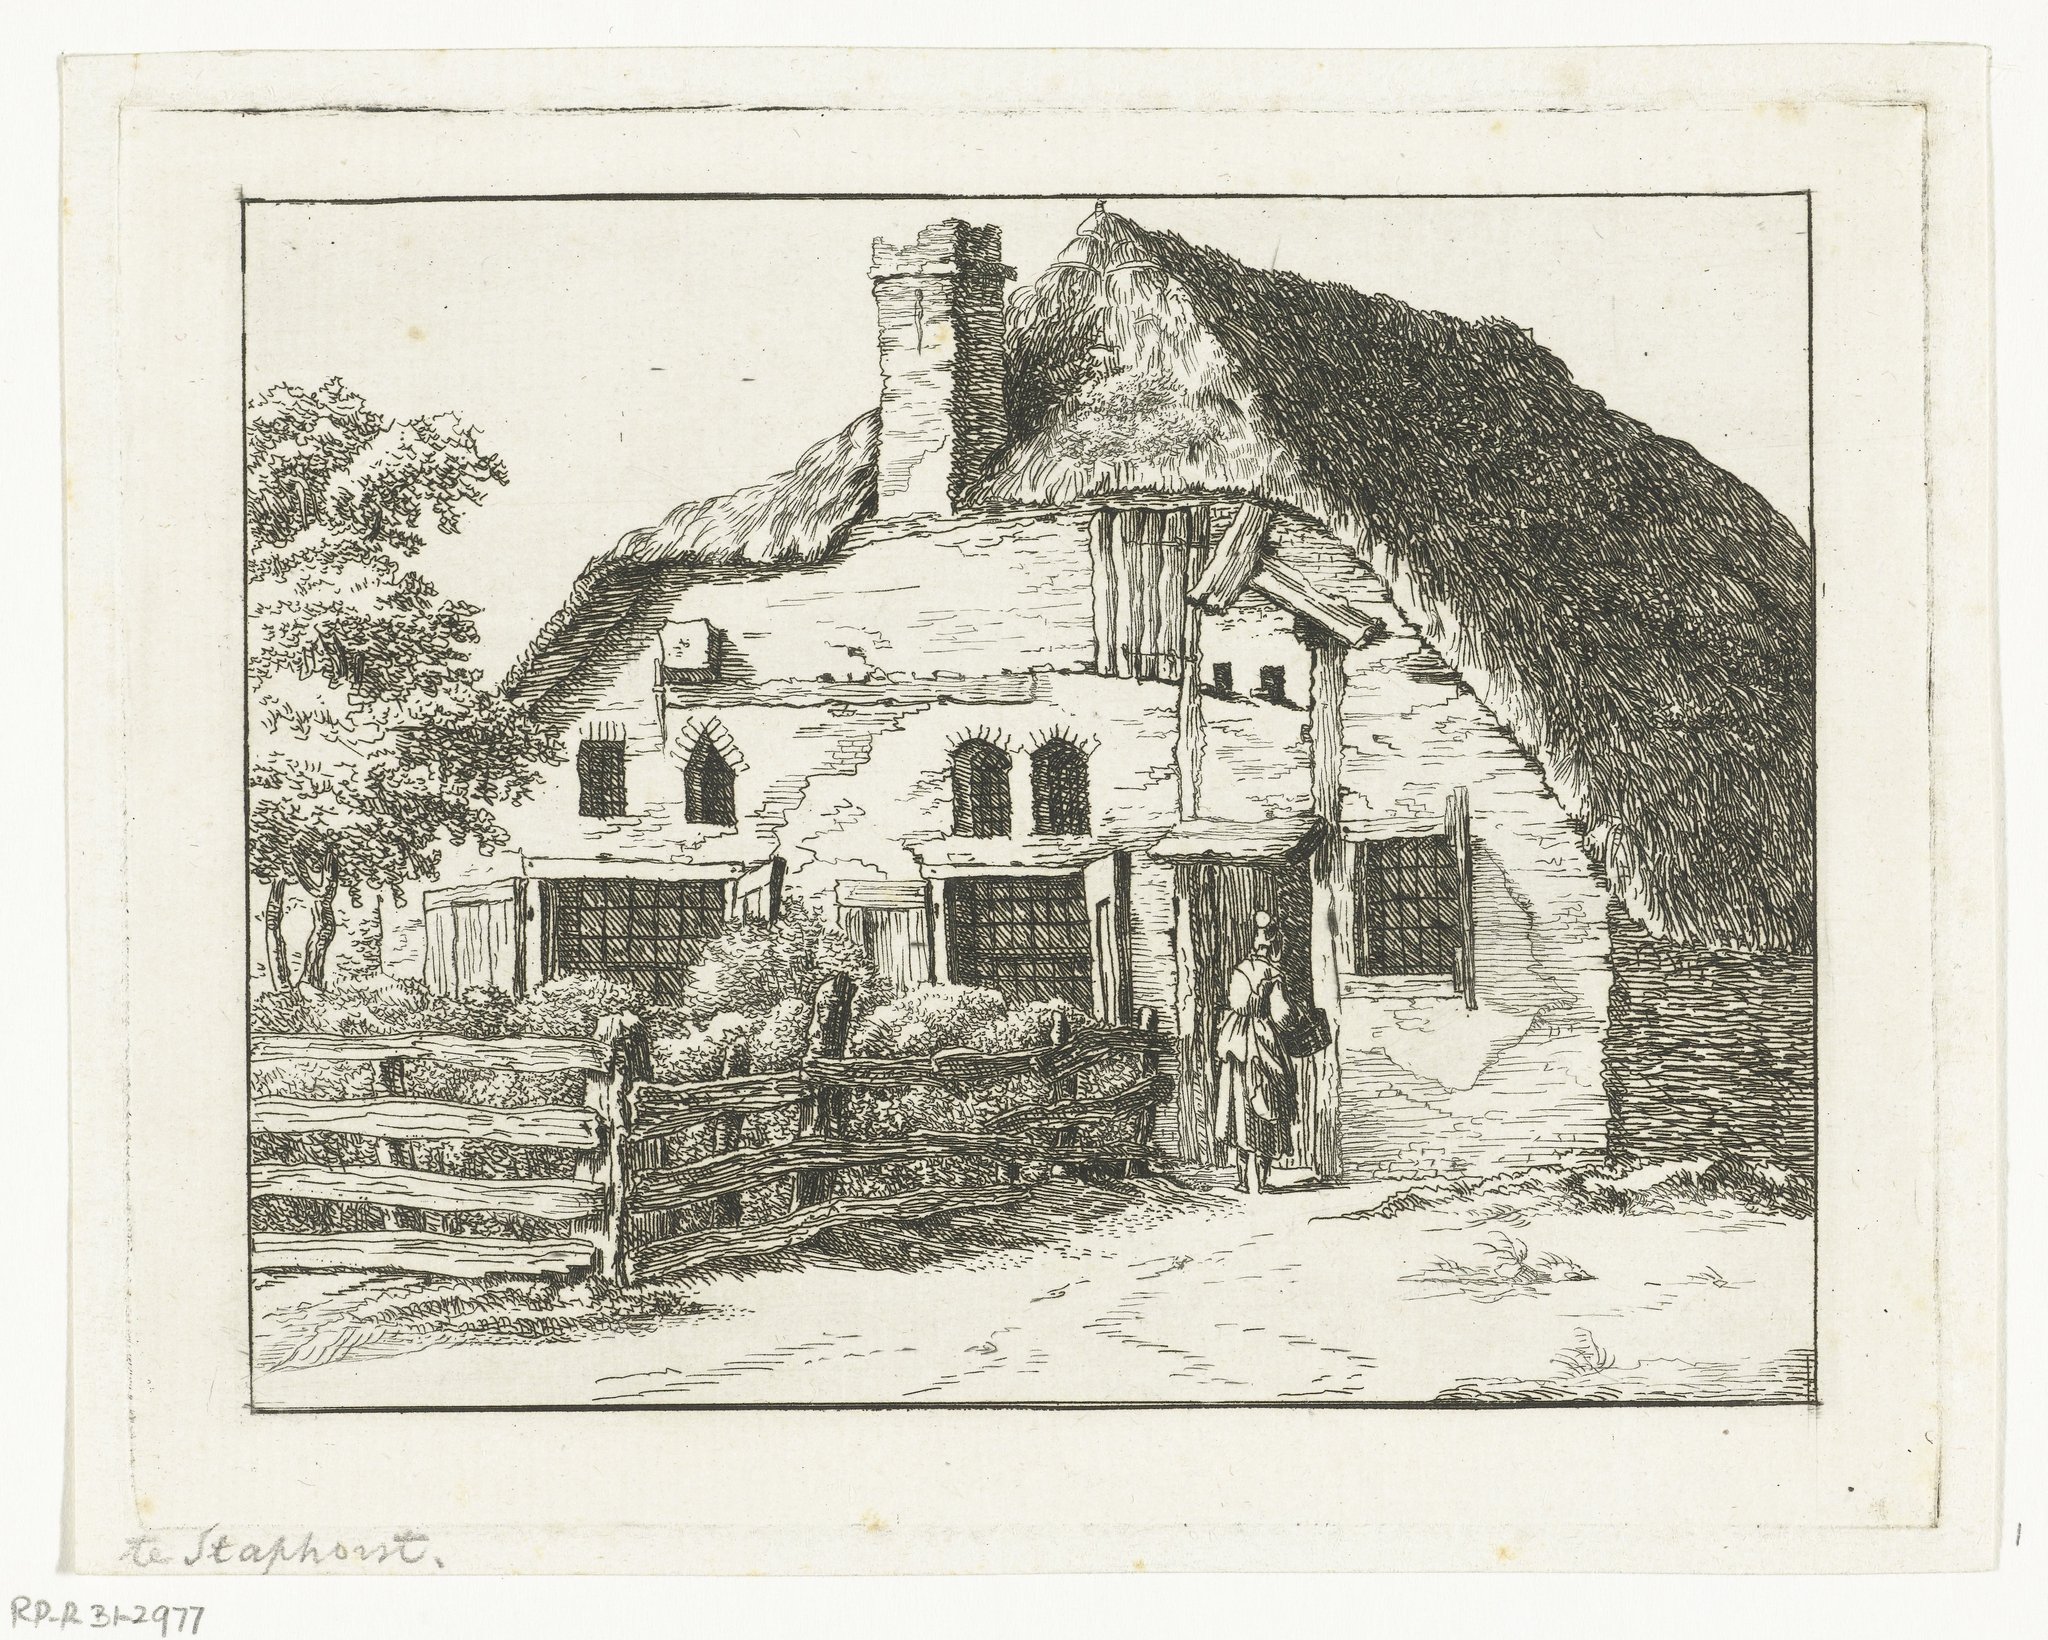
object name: print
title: Vrouw met een mand voor een huis te Staphorst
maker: anthonie van den bos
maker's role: draughtsman, print maker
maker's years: 1763-1838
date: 1778-1838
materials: paper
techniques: etching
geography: netherlands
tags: farm (building)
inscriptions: collector's mark: Lugt 2228, inscription: ‘te Staphorst’